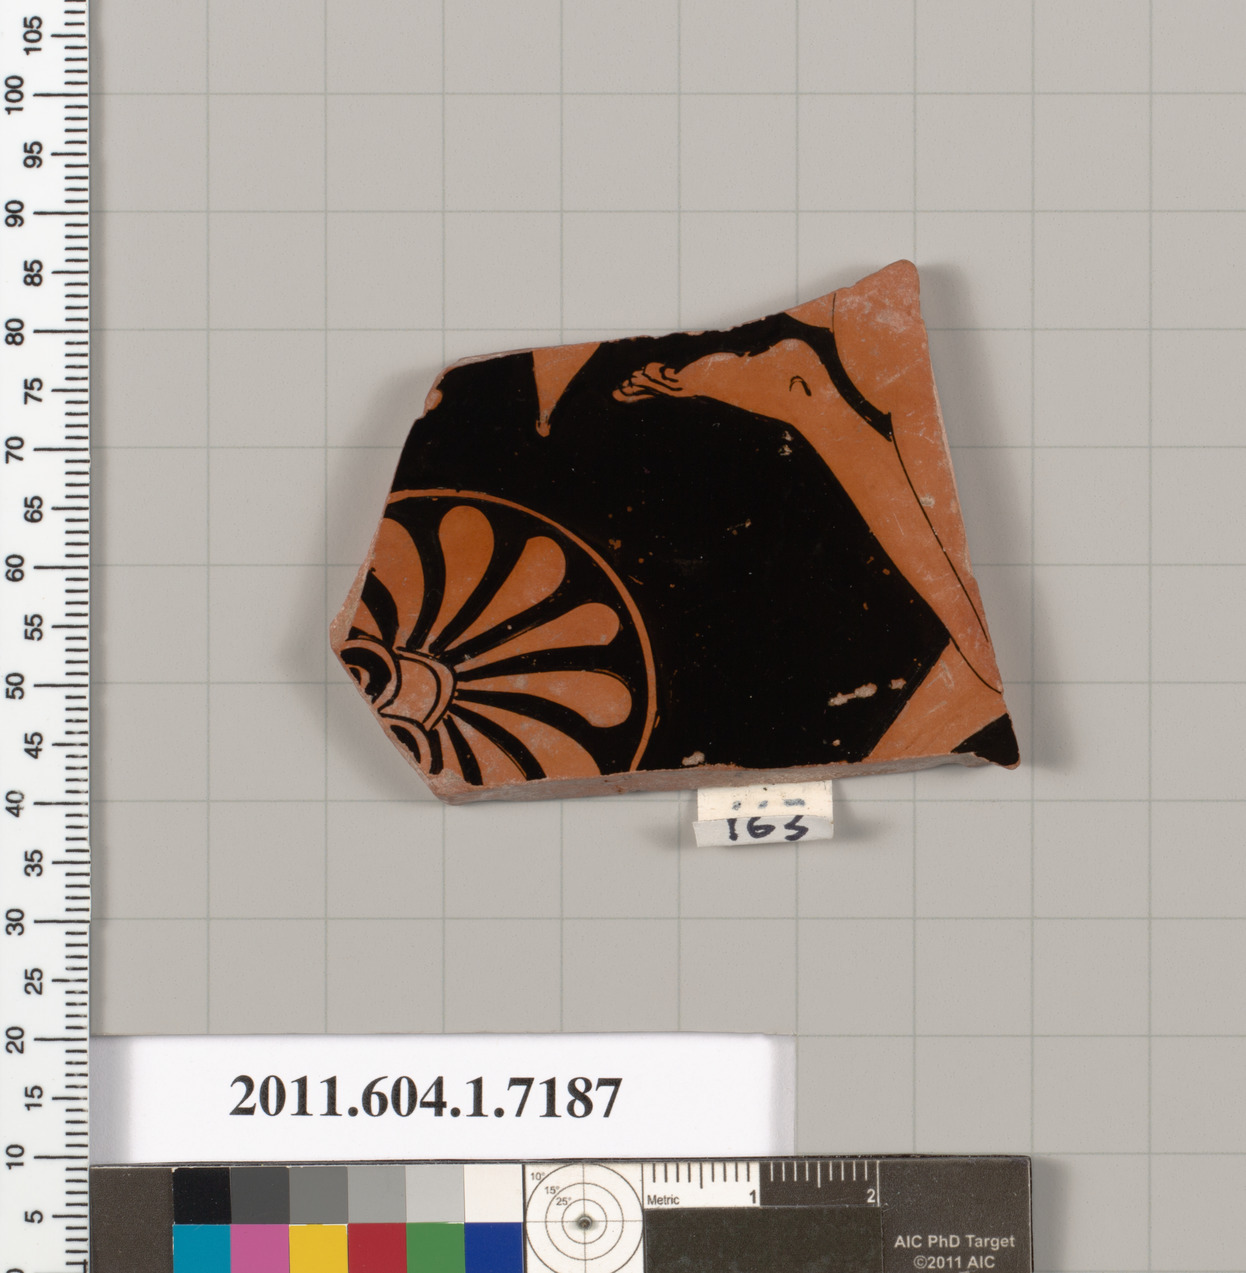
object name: kylix fragment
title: Terracotta fragment of a kylix (drinking cup)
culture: greek, attic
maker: makron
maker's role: artist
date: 500-480 BCE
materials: terracotta